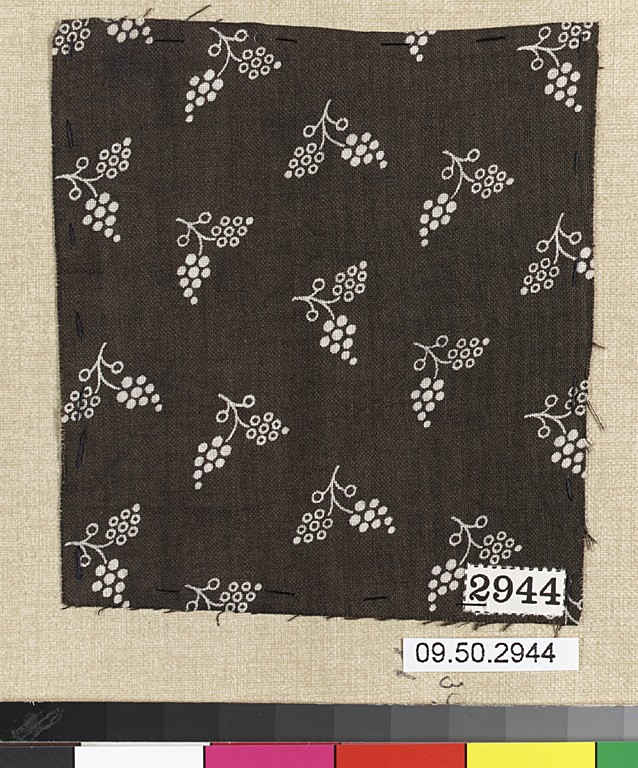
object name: piece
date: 1801-1900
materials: cotton